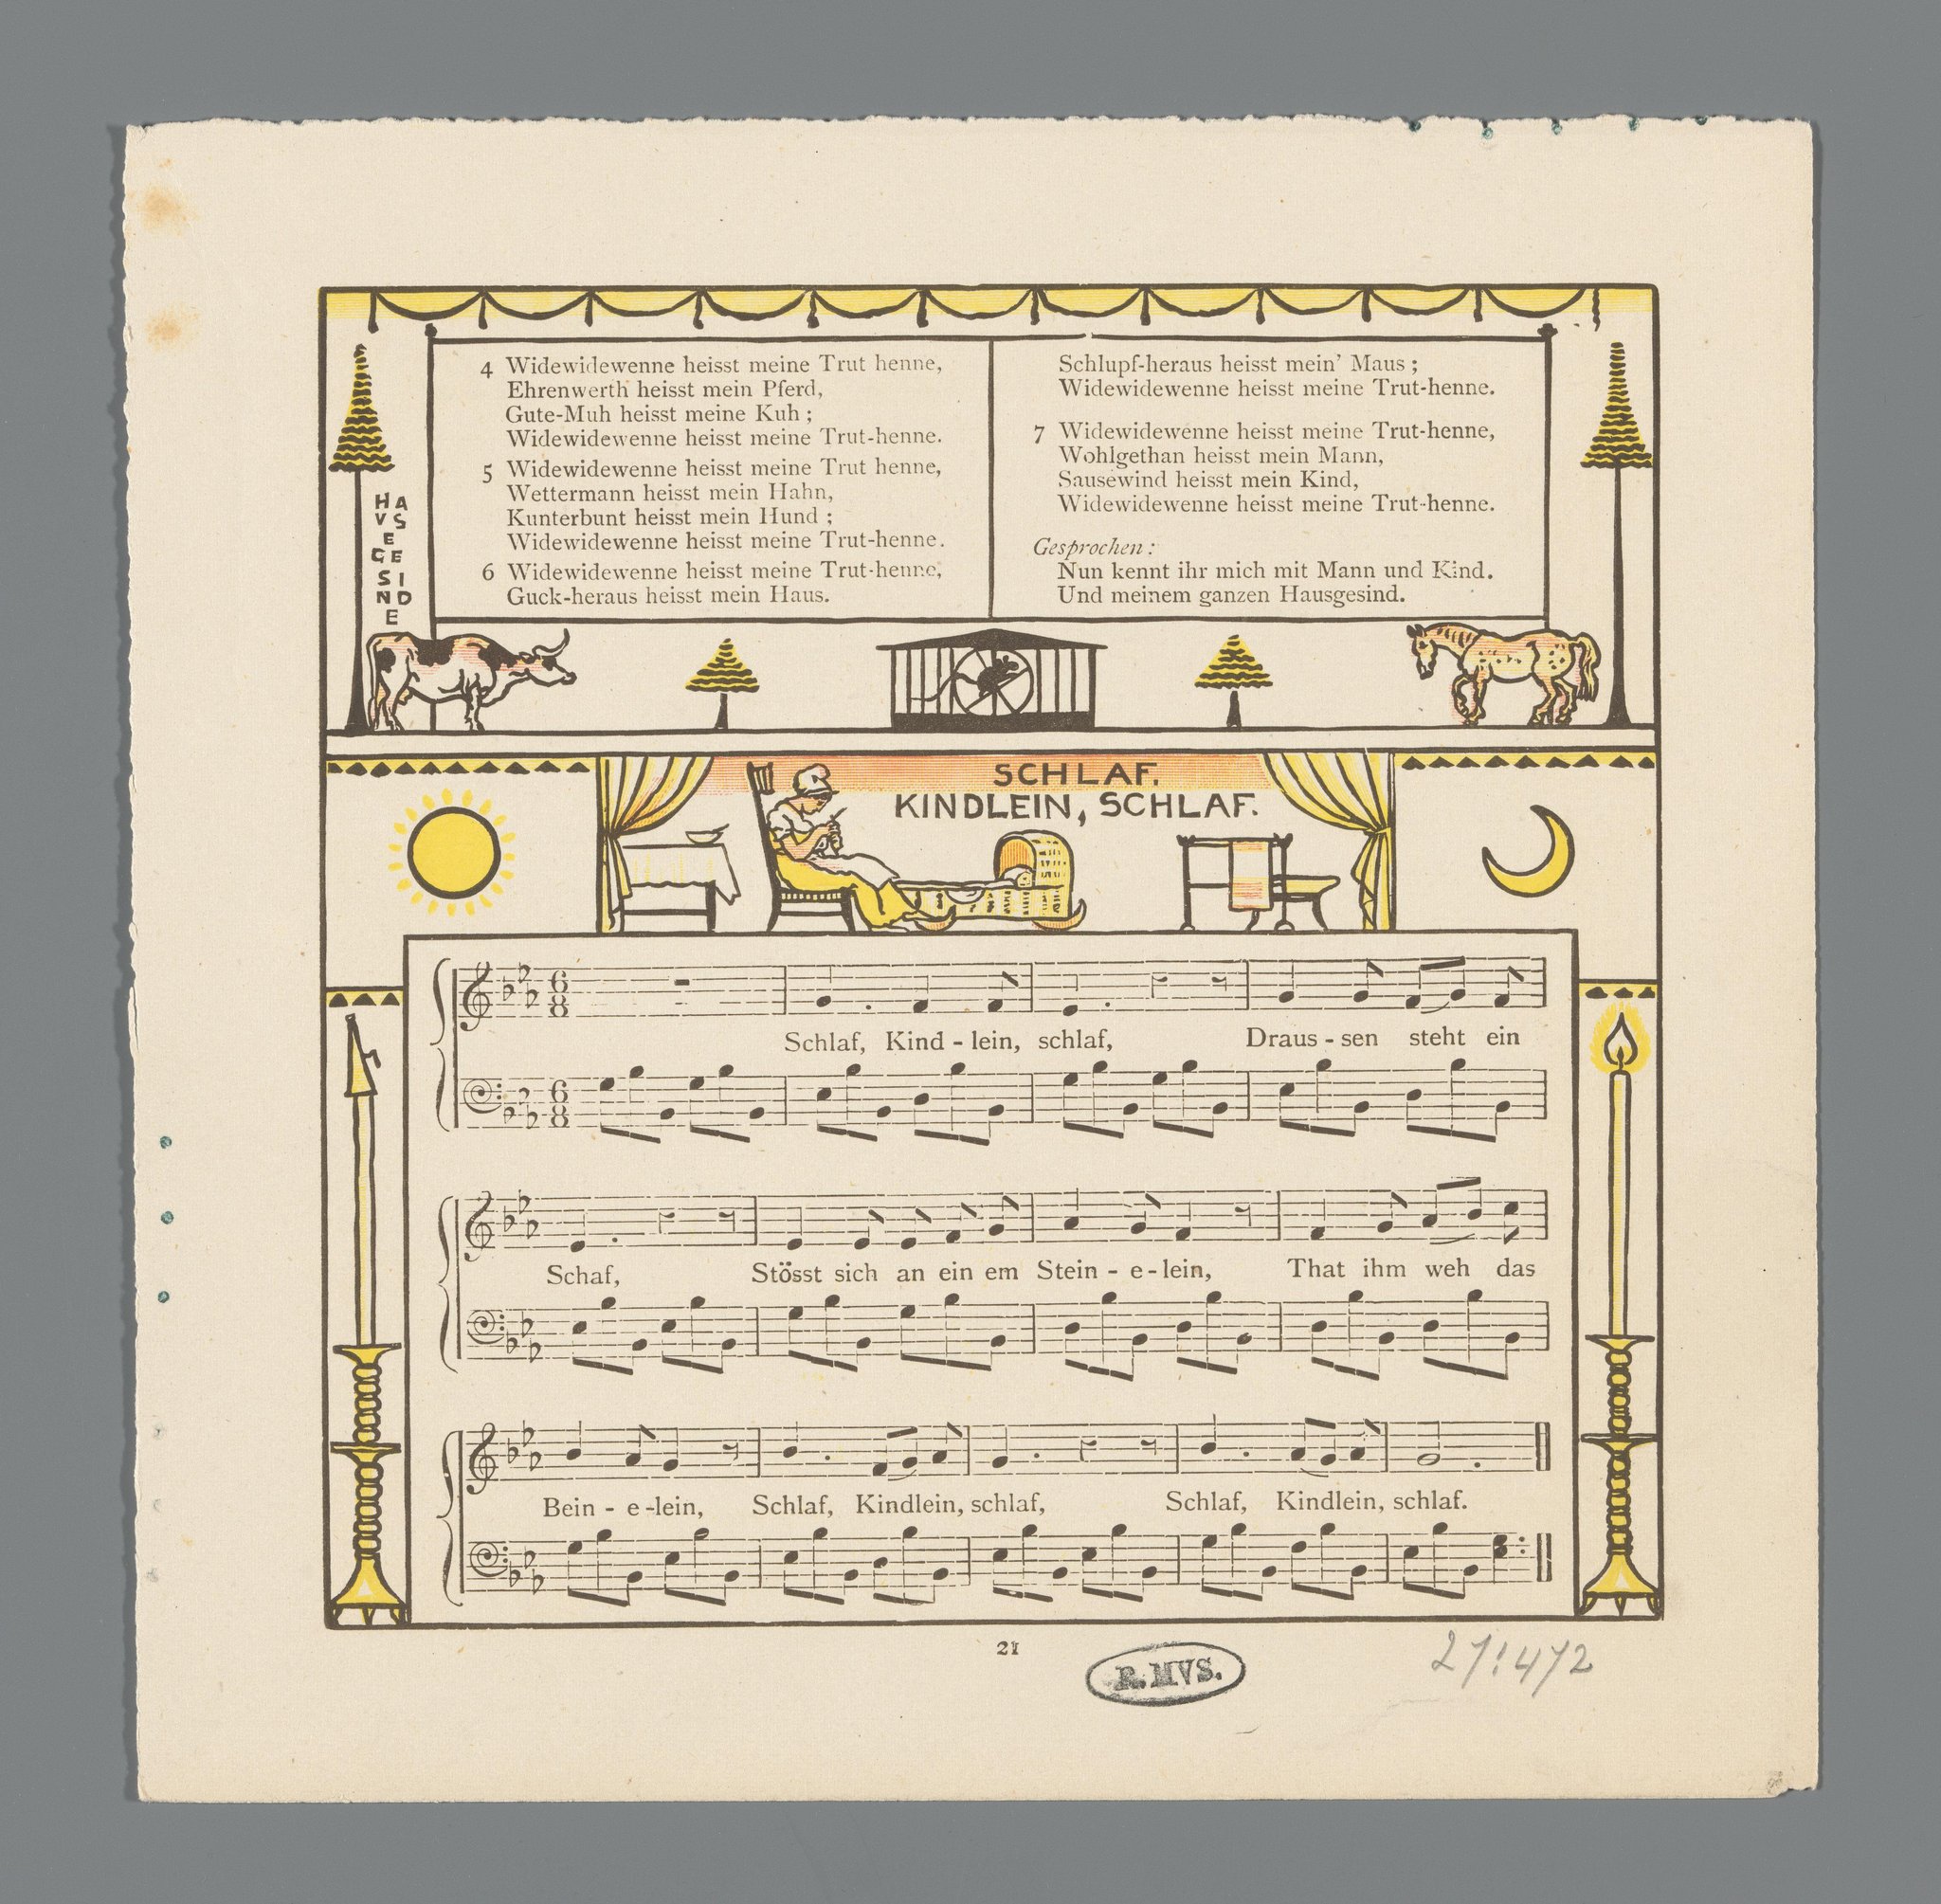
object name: book illustration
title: Schlaf, kindlein, schlaf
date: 1878-1927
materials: paper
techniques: wood engraving, letterpress printing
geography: london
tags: interior of the house, cradle, crib, mother and baby or young child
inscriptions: collector's mark: Lugt 2228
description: Prent uit: The baby's bouquet, a fresh bunch of old rhymes and tunes. Londen: Routledge & Sons, [1878]. Of een latere uitgave.